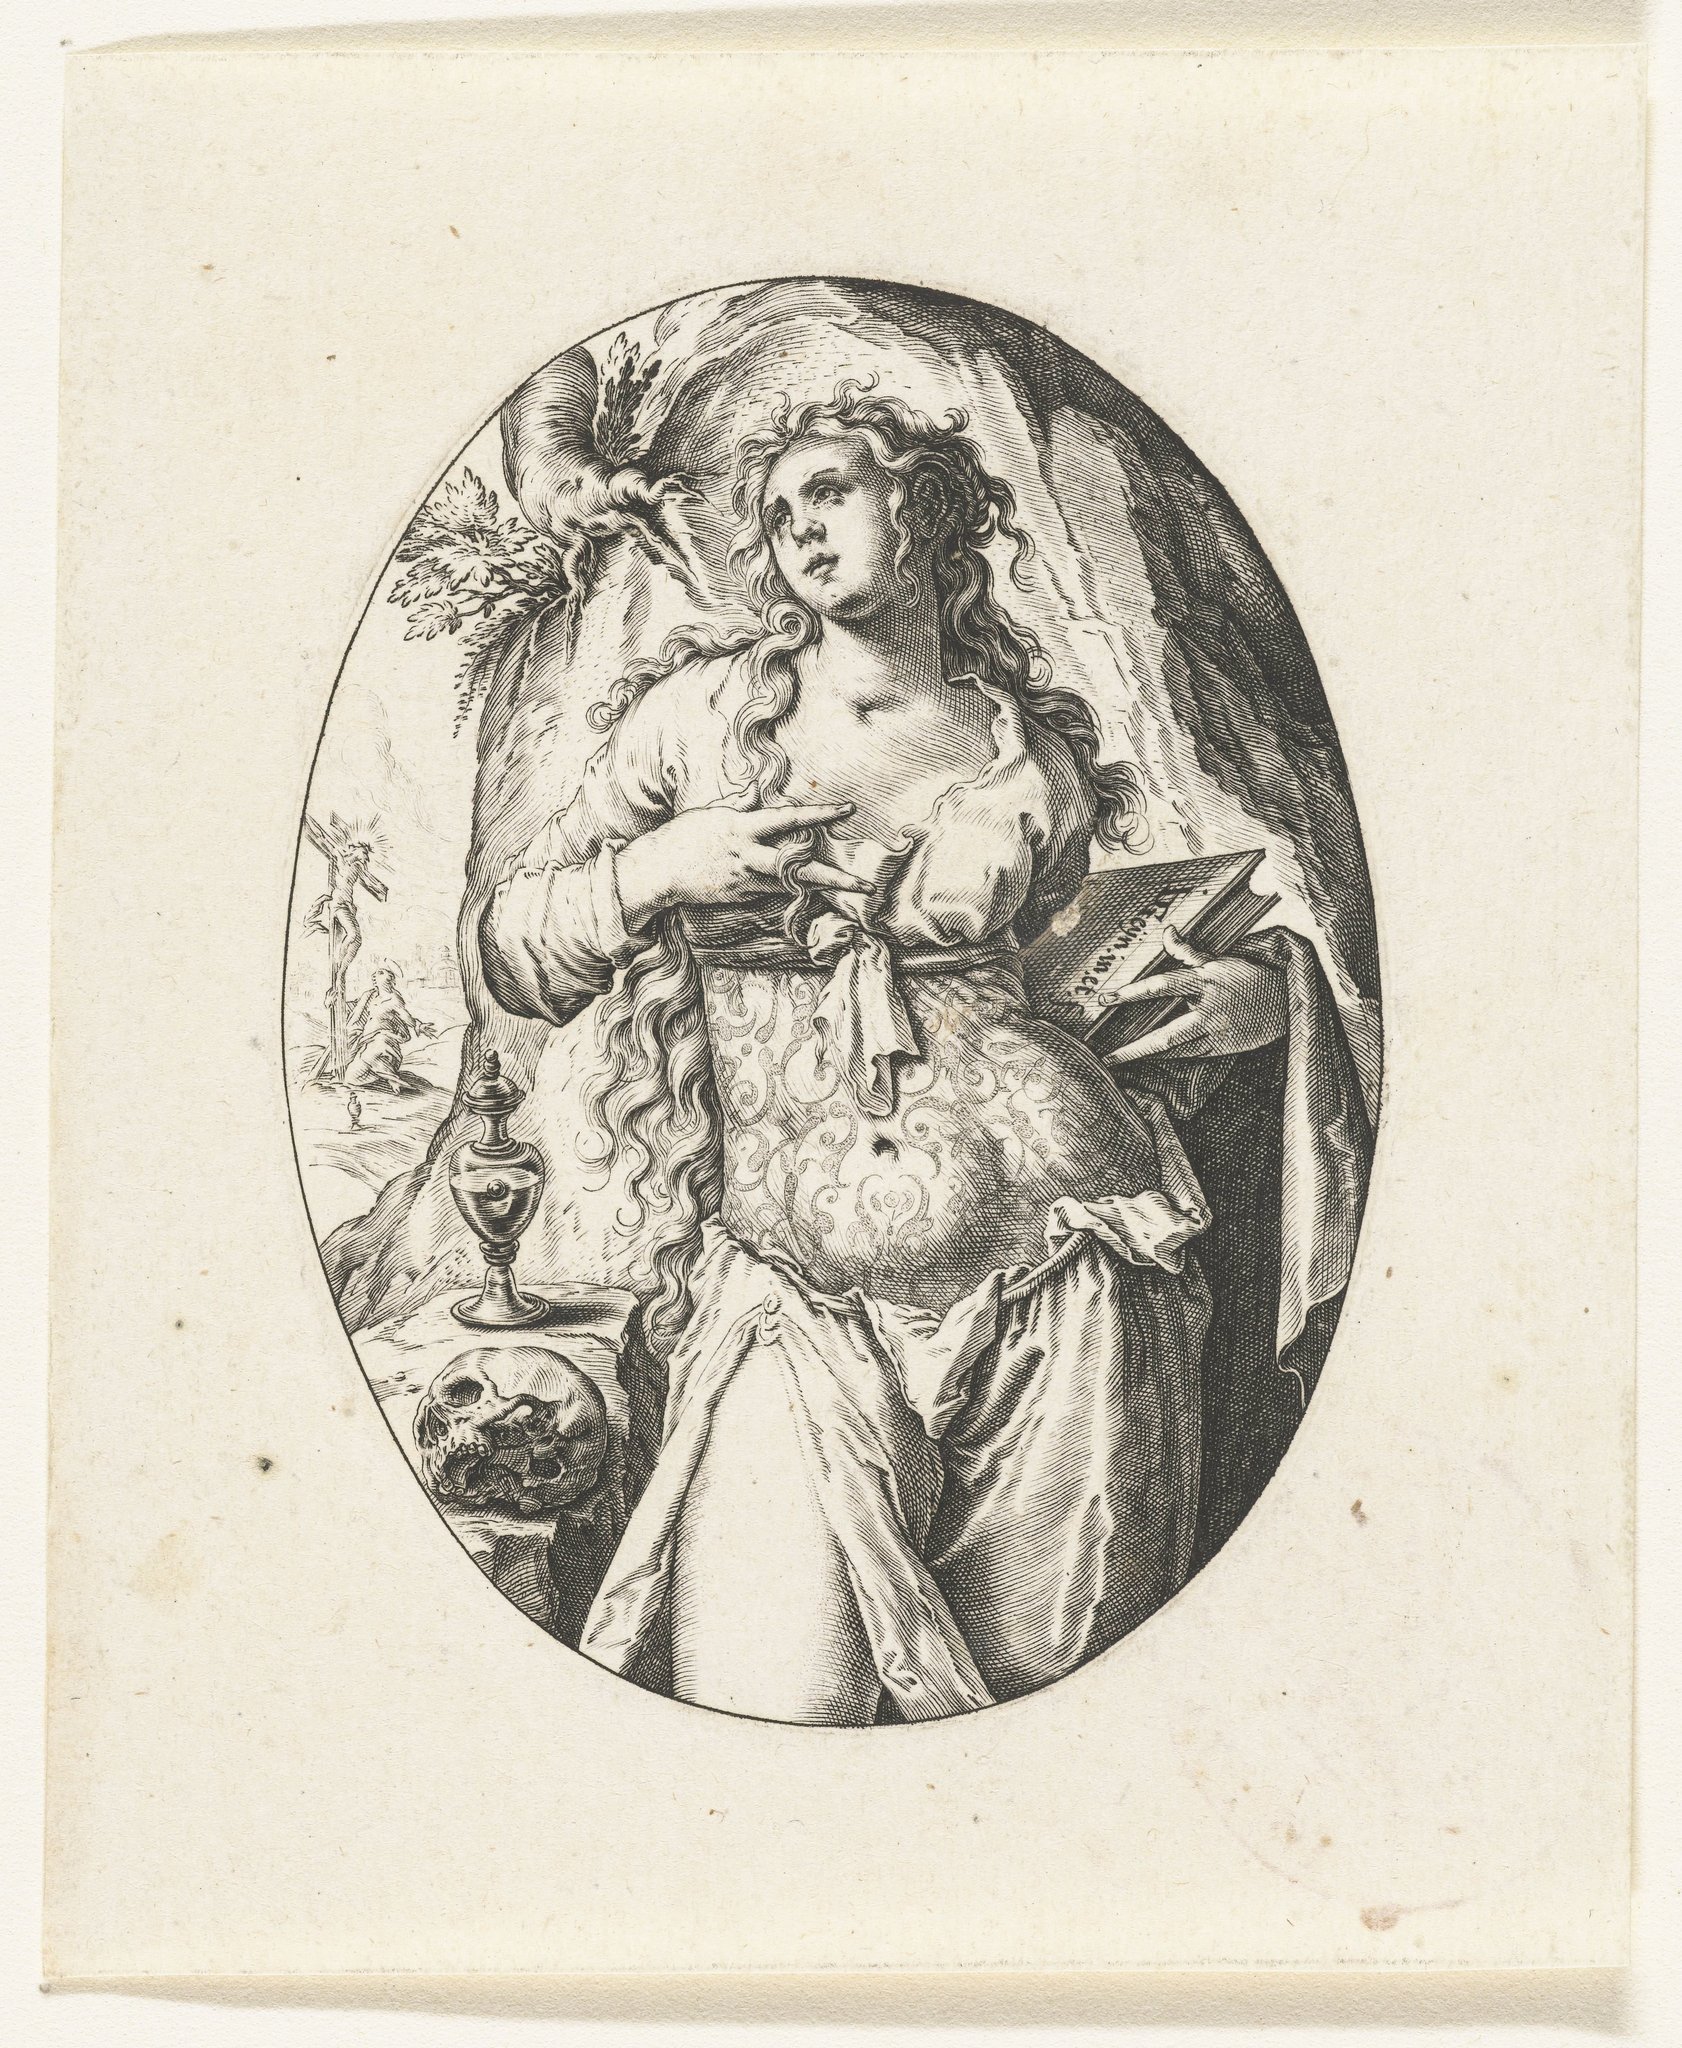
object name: print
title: De boetvaardige Maria Magdalena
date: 1588-1592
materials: paper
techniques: engraving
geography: netherlands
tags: the penitent harlot mary magdalene; possible attributes: book (or scroll), crown, crown of thorns, crucifix, jar of ointment, mirror, musical instrument, palm-branch, rosary, scourge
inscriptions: collector's mark: Lugt 240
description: Ovale voorstelling van Maria Magdalena, ten halven lijve, in de linkerhand een boek, staand in een rotsachtige omgeving, naast haar een zalfpot en een schedel. Op de achtergrond Maria Magdalena aan de voet van de gekruisigde Christus.